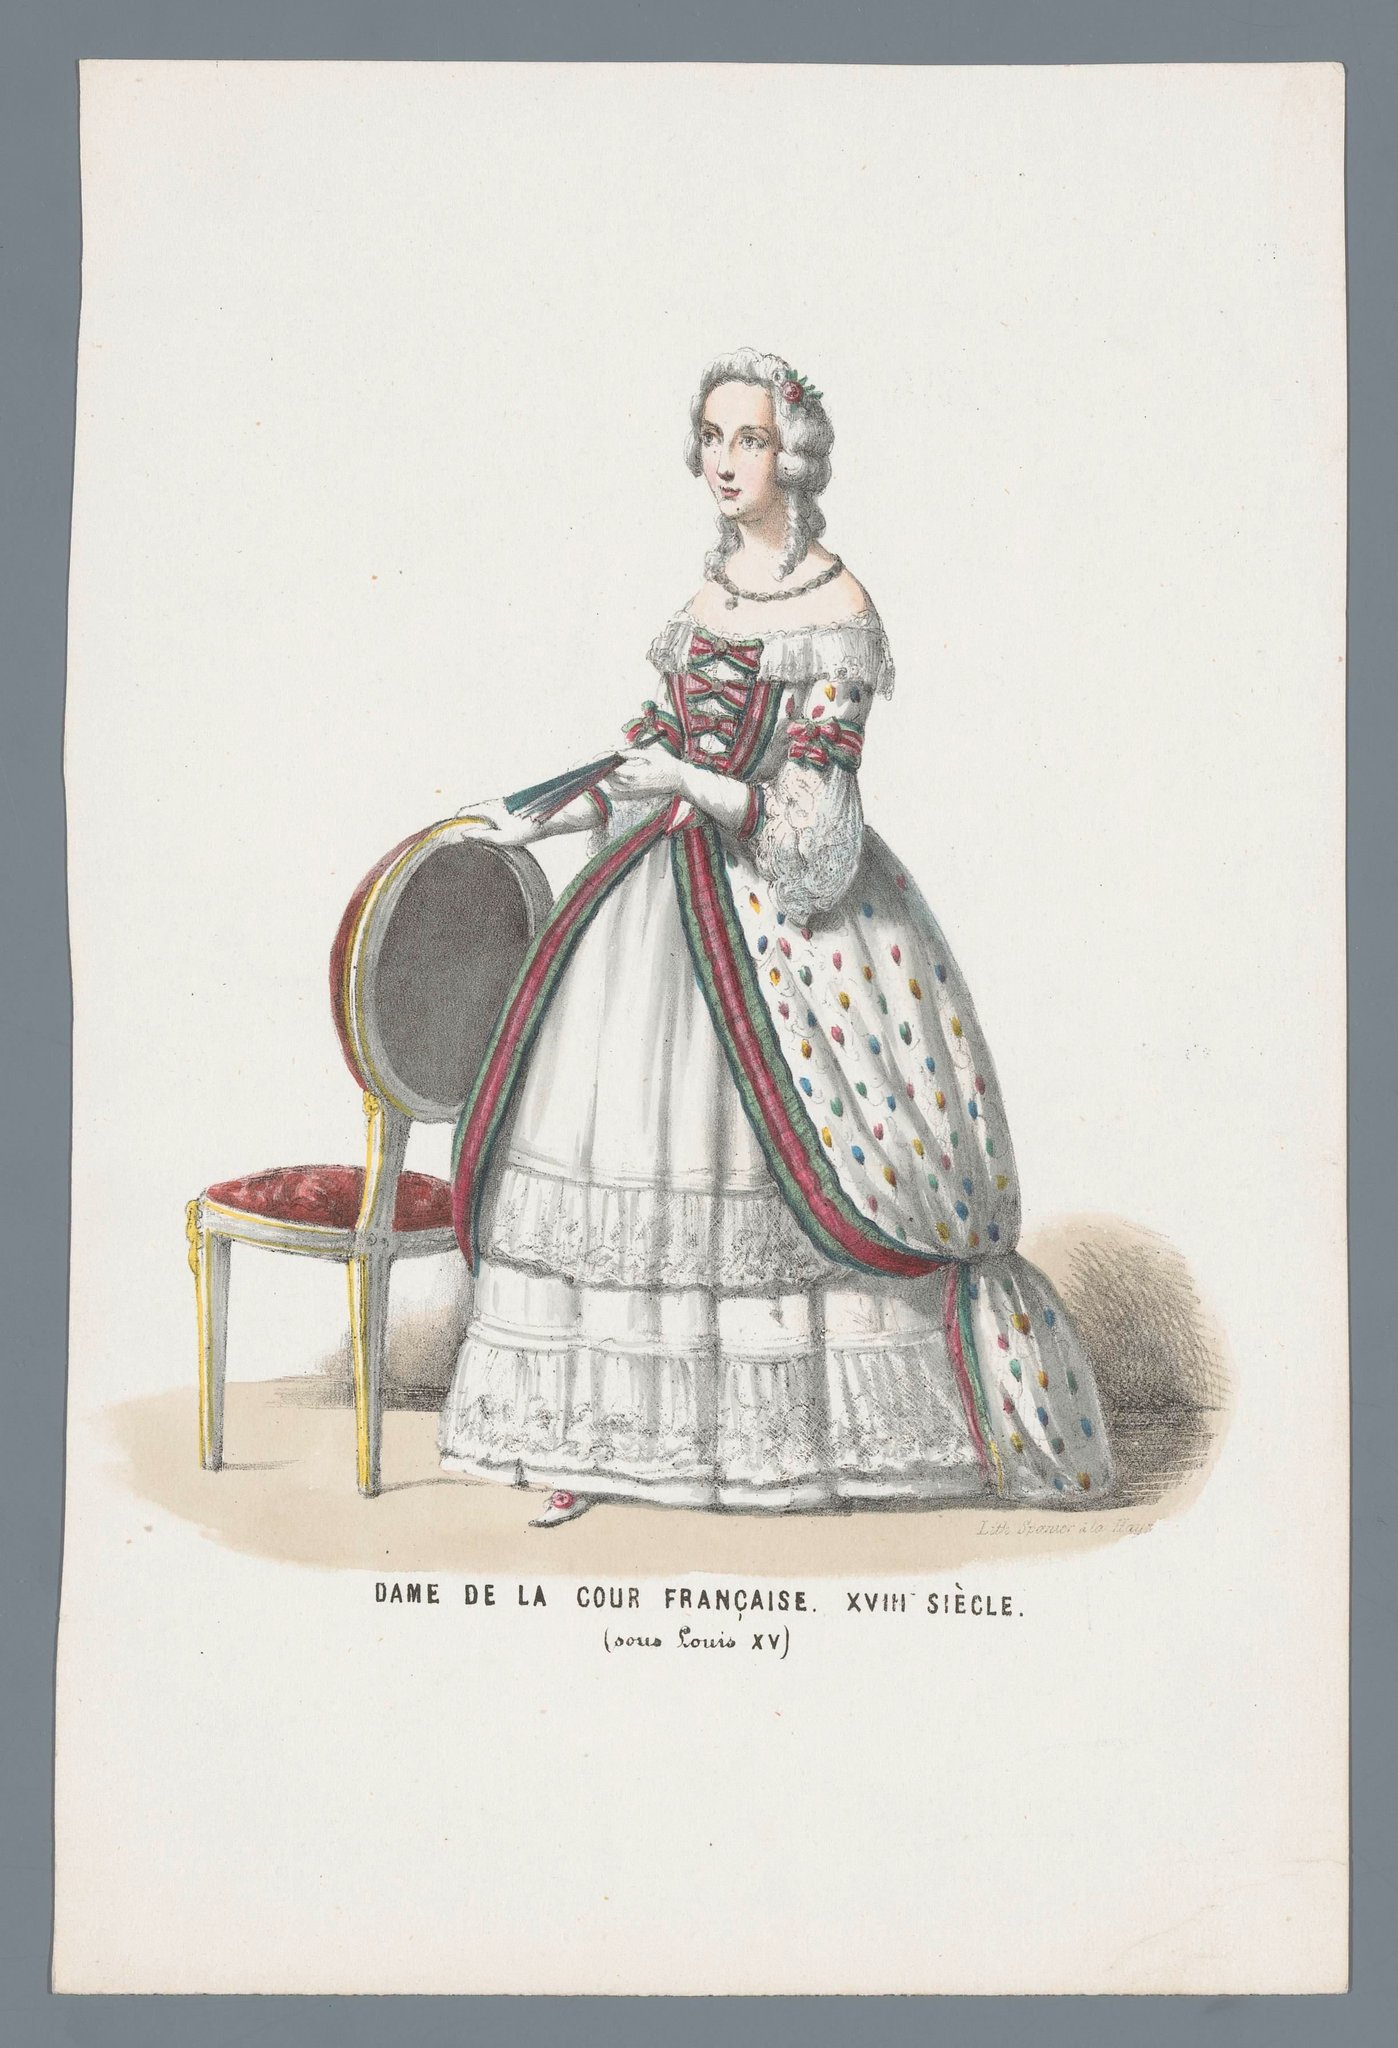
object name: costume print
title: Dame de la Cour Française. XVIII Siècle (sous Louis XV)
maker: elias spanier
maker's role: print maker, printer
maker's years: 1821-1863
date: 1840-1850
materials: paper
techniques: hand coloring, lithograph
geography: the hague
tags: historical costume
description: Vrouw in historisch kostuum van een hofdame aan het Franse hof van Lodewijk XV, 18e eeuw. Voorstelling toegevoegd aan het plaatwerk over het gekostumeerd bal gehouden op het paleis van de prins van Oranje (de latere koning Willem III) in Den Haag op 26 februari 1845.